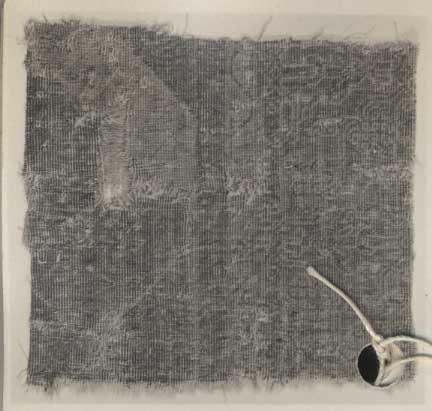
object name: carpet fragment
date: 1501-1600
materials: wool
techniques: asymmetrically knotted pile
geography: egypt